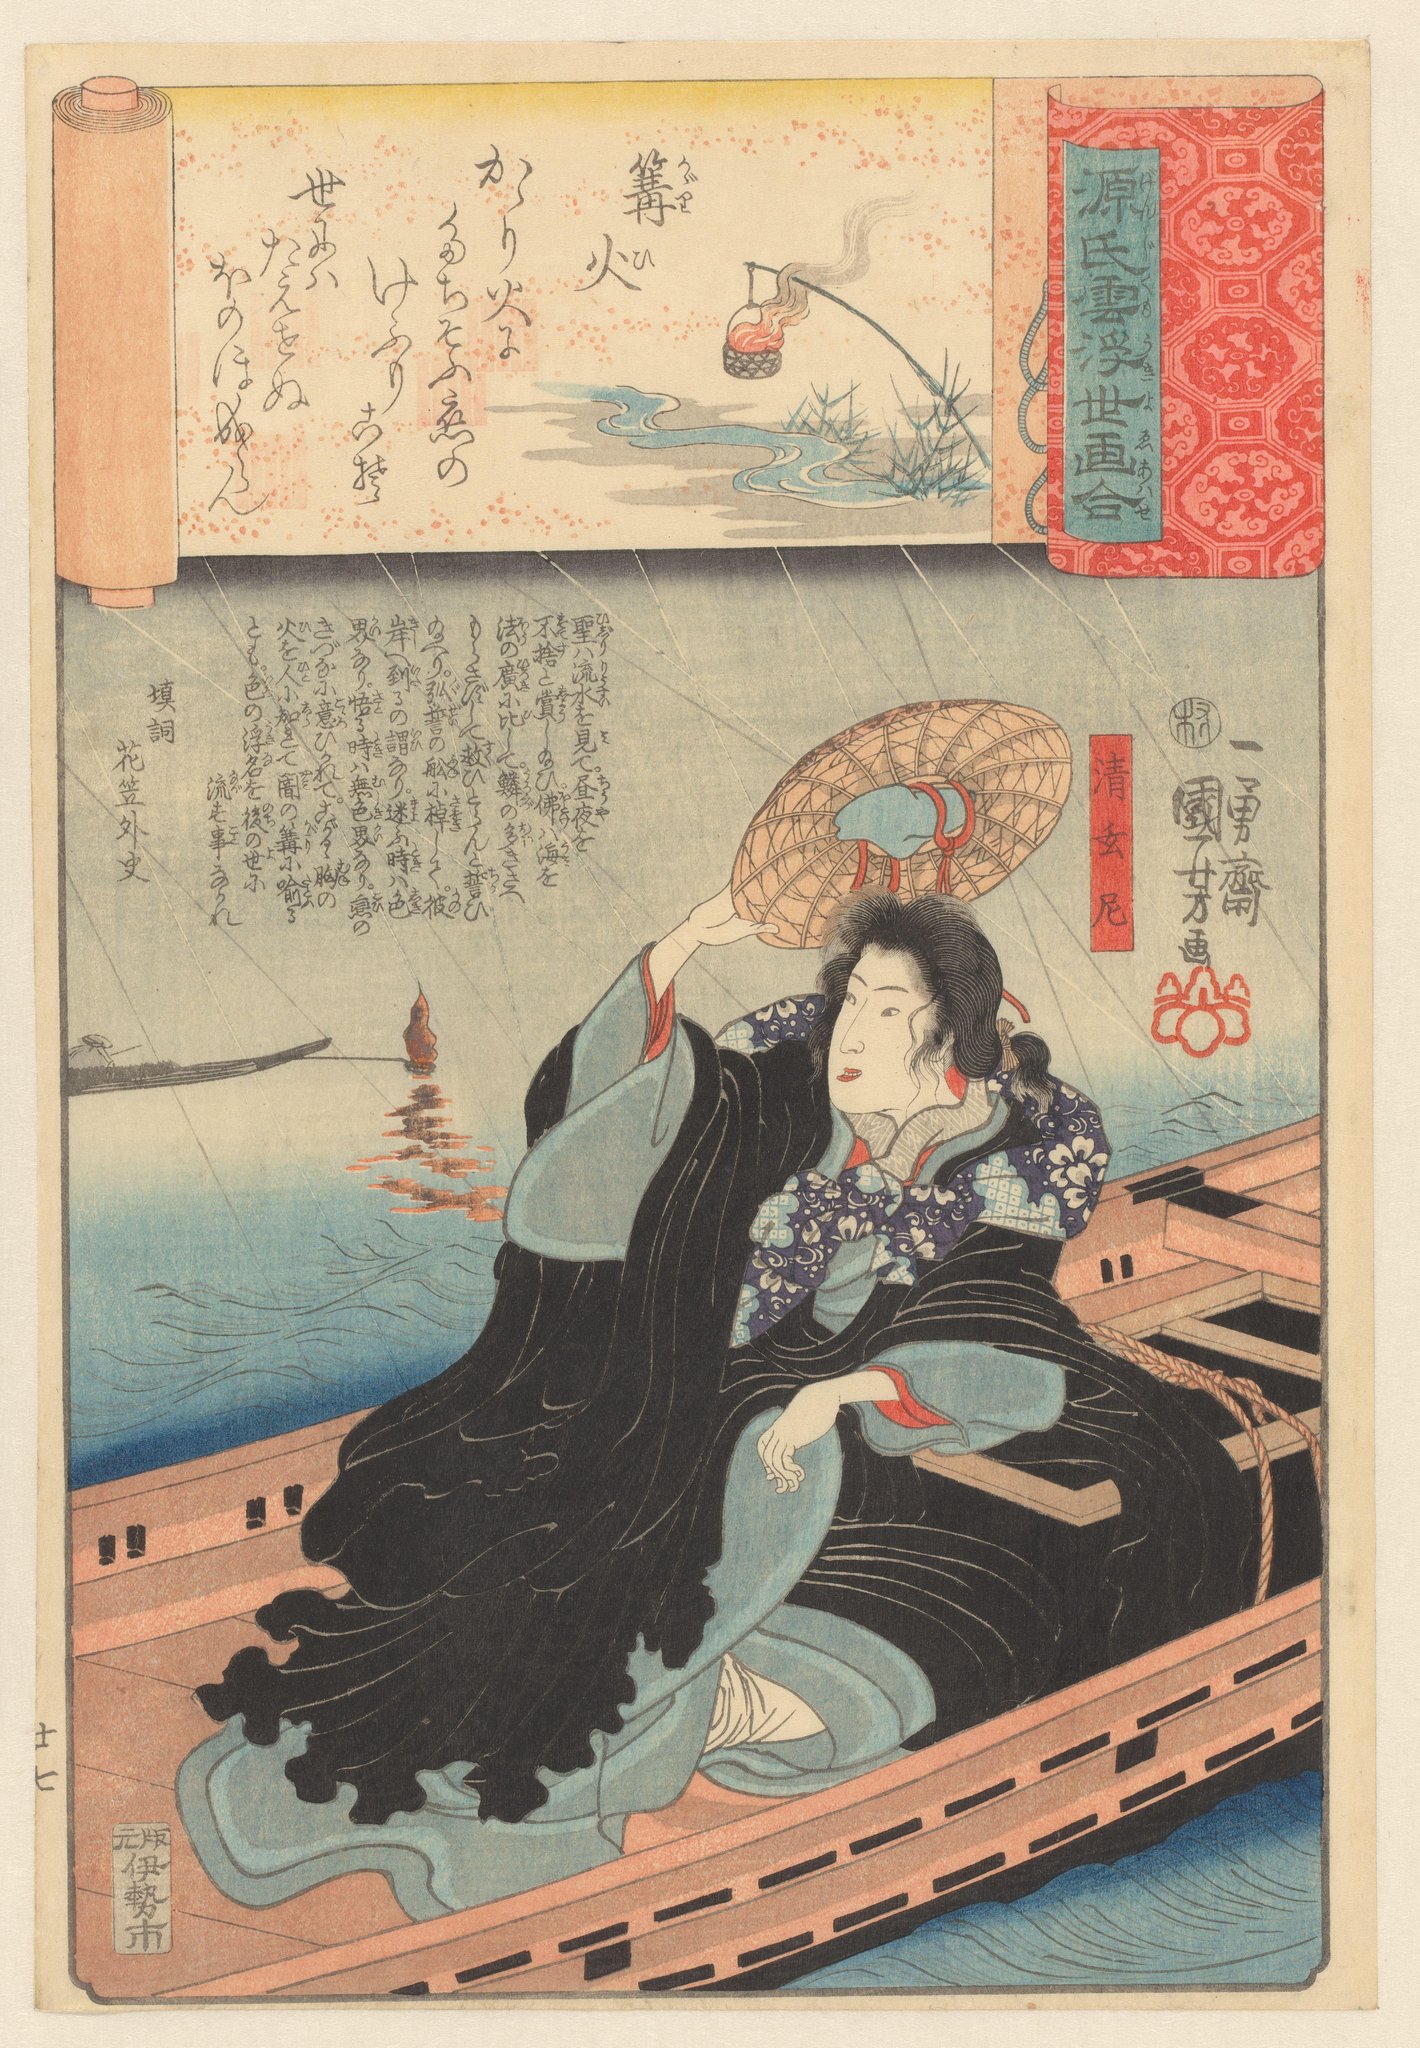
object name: print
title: Ukiyo-e parallels to the cloudy chapters of Genji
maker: utagawa kuniyoshi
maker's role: draughtsman, print maker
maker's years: 1798-1861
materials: paper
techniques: woodcut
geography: japan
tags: adult woman, rowing-boat, canoe, etc., rain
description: De non Seigen zittend tegen een zwarte kist, in een veerboot. Deze scene verwijst naar hoofdstuk 27 van het Verhaal van Genji.